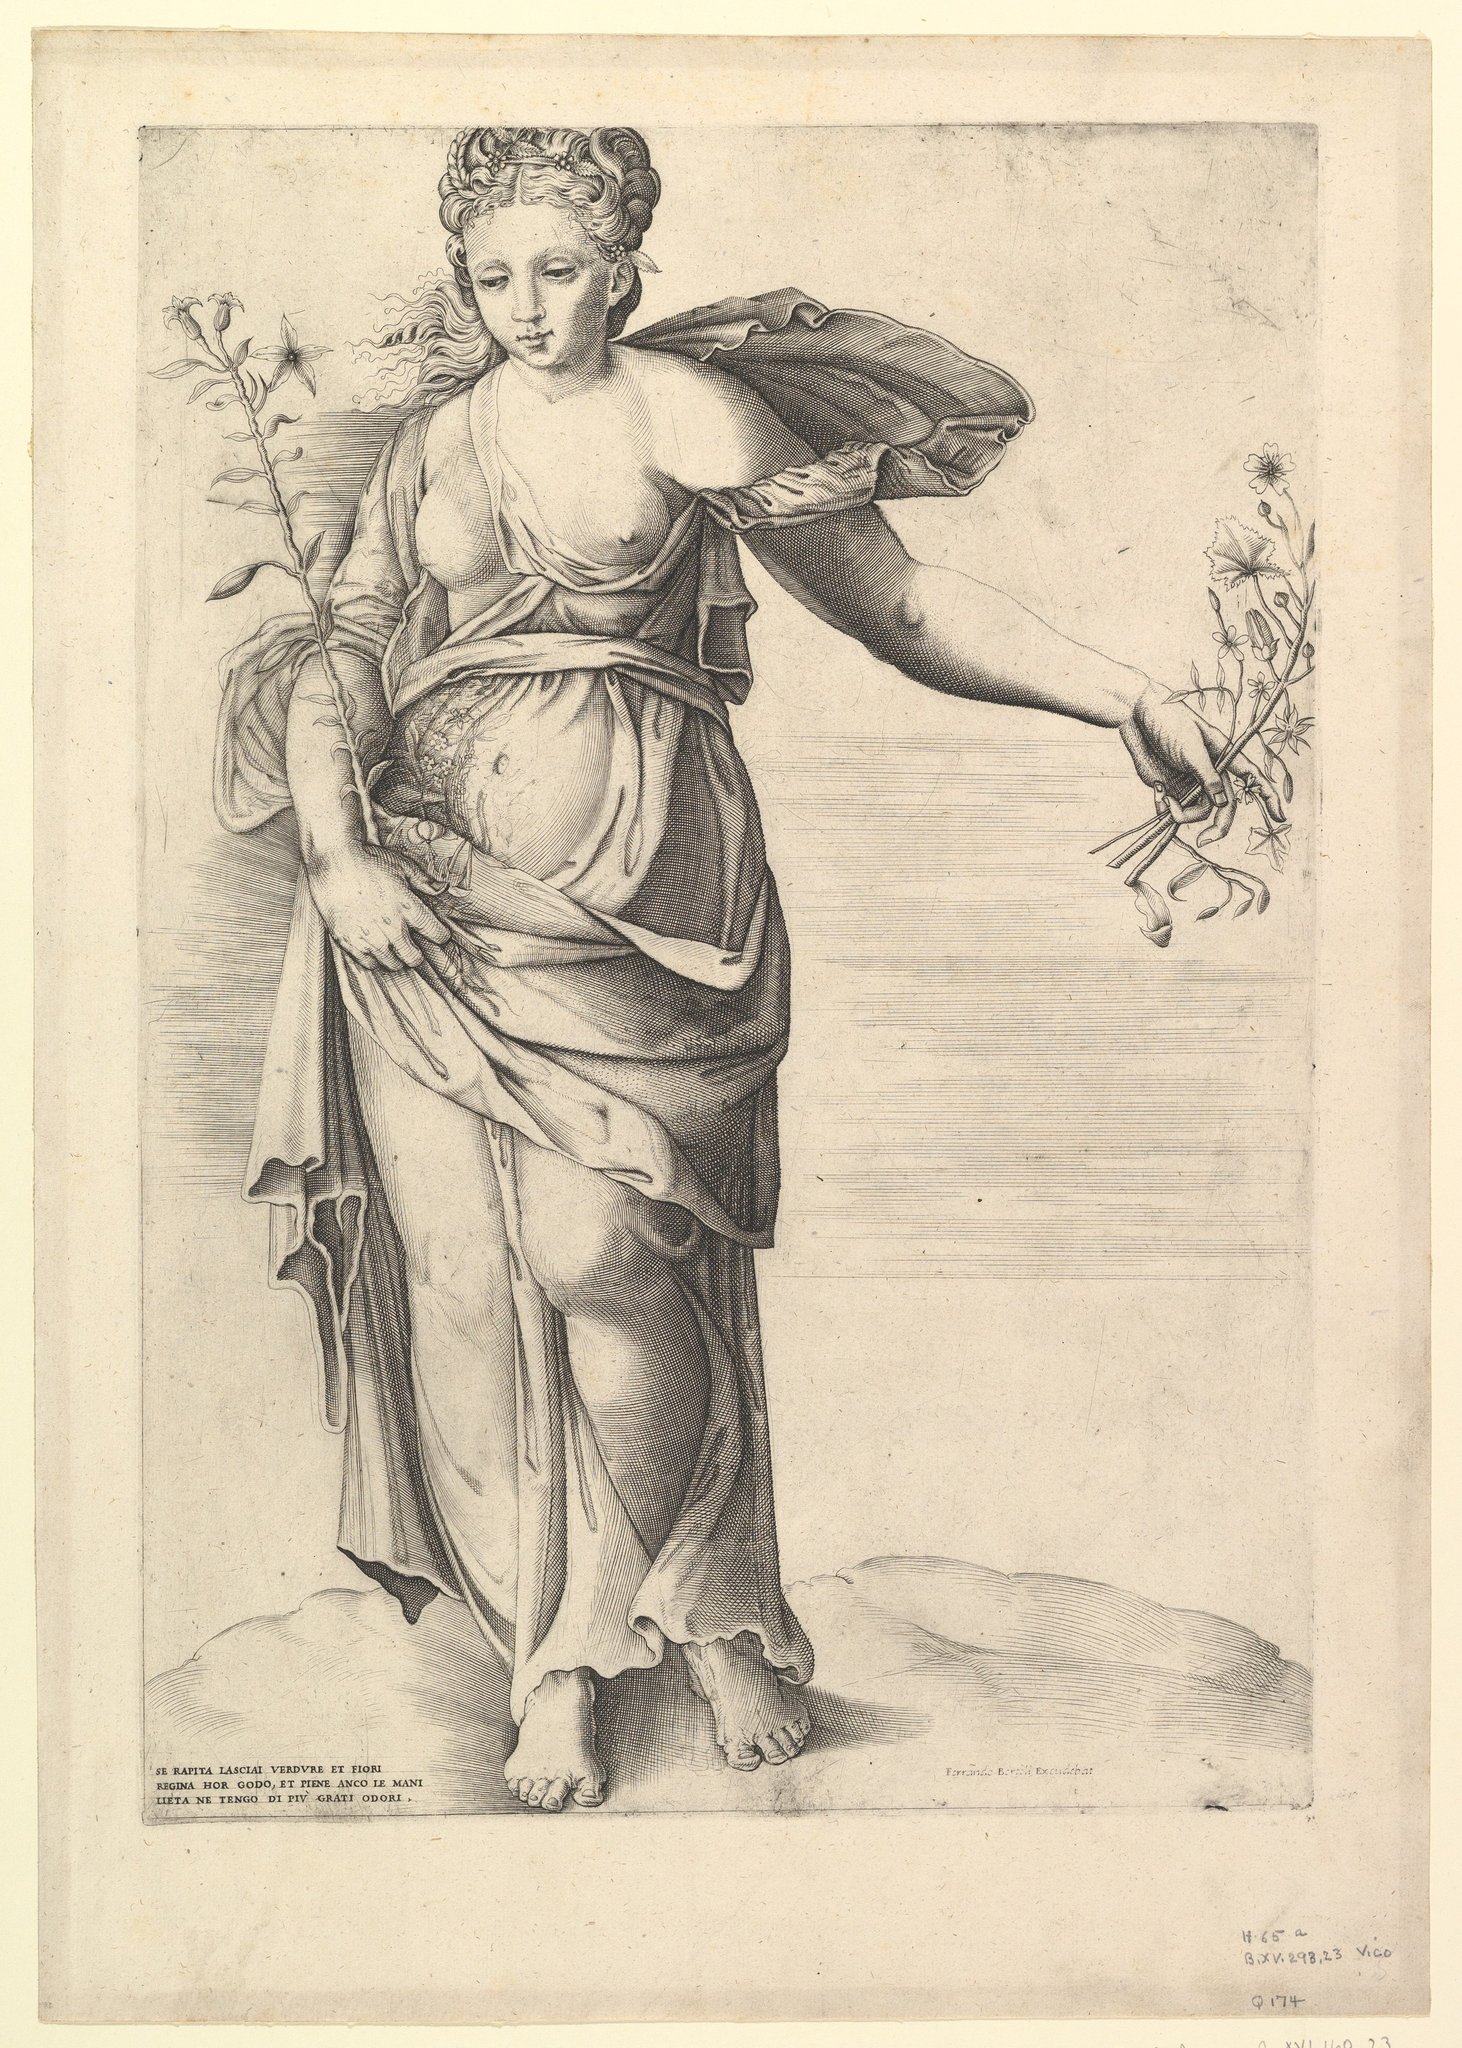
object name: print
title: Flora, from "Speculum Romanae Magnificentiae"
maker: anonymous, italian, 16th century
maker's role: artist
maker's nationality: italian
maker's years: 1500-1600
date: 1534-1566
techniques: engraving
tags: female nudes,flowers